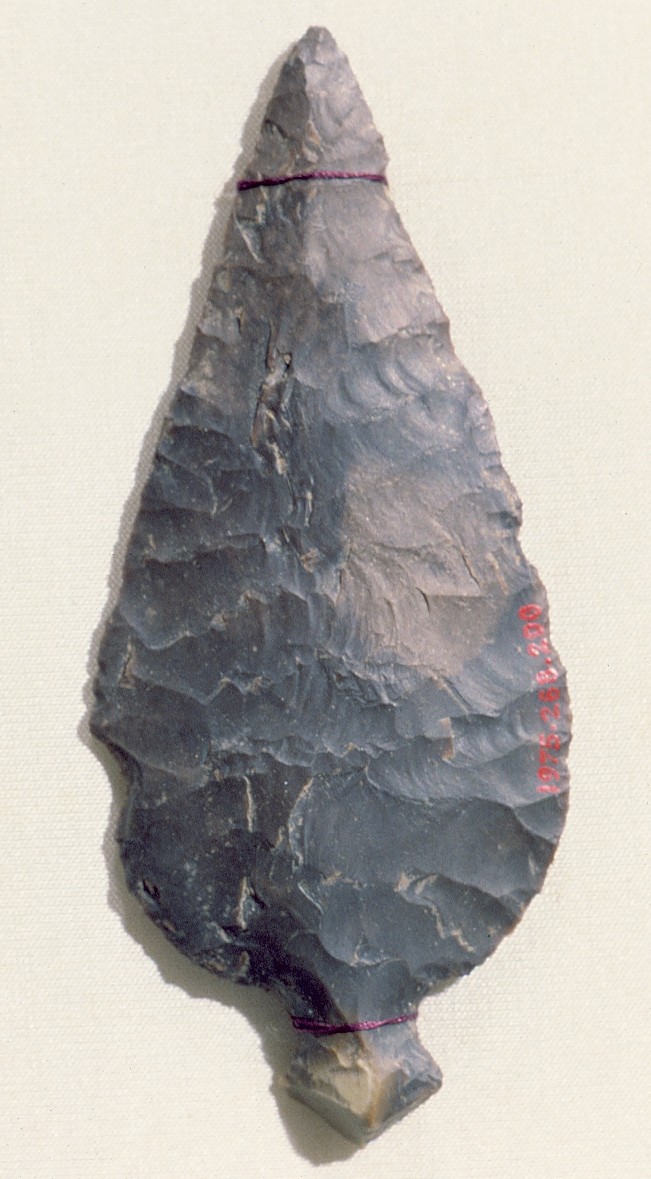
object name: spearhead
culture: japanese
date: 1500-1000 BCE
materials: stone